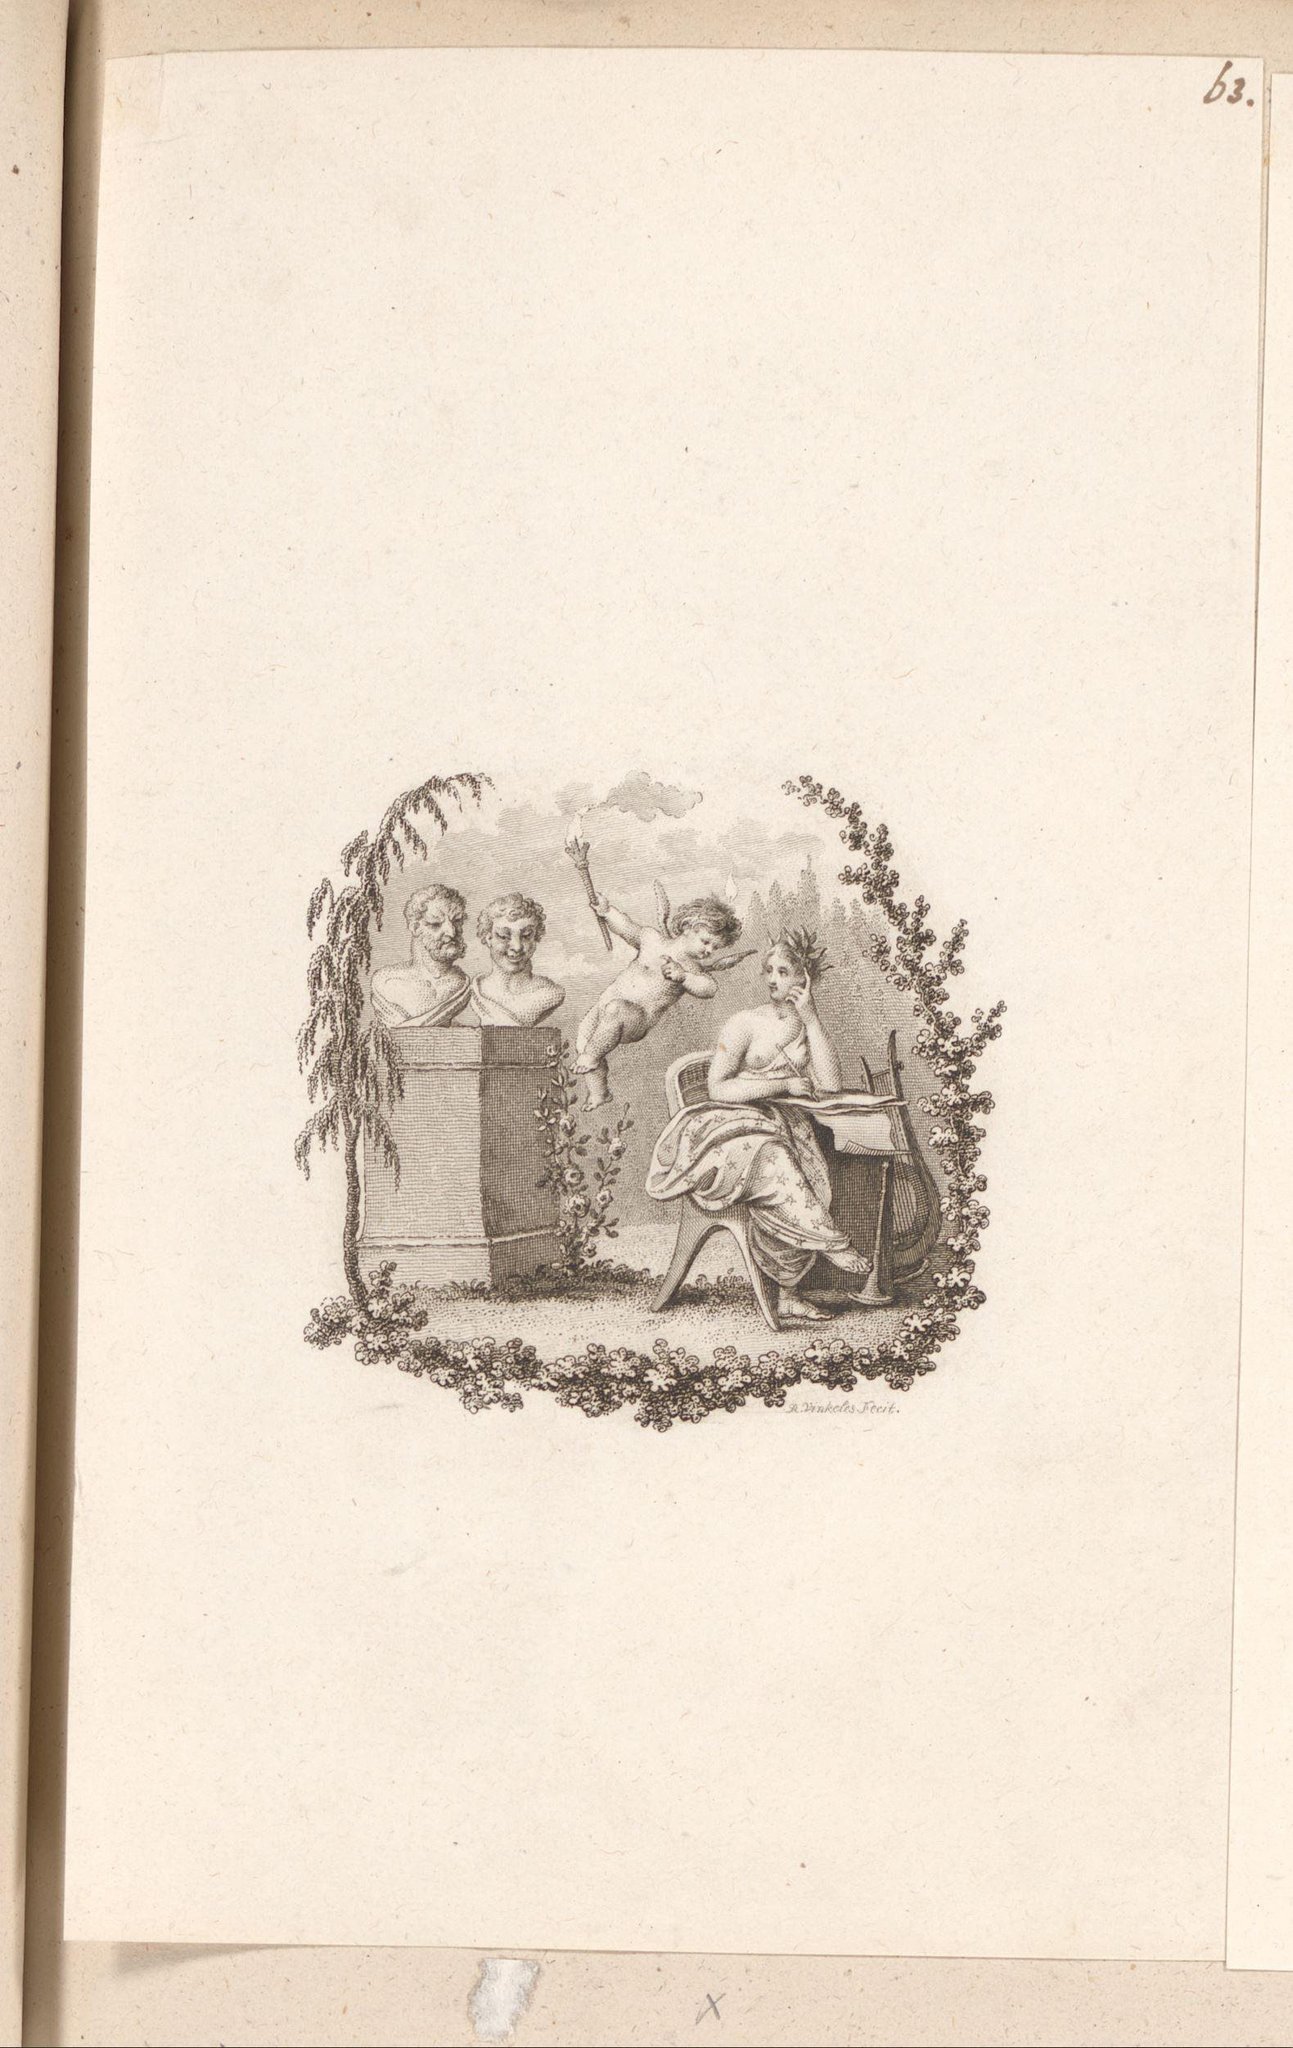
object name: album leaf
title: Erato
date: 1813-1815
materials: paper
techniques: engraving, etching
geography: amsterdam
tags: title-page, erato (one of the muses); 'erato' (ripa)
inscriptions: inscription: ‘63’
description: Erato, de muze van de lyriek en liefdespoëzie, zit aan een schrijftafel. Tegen de tafel staat een fluit en een lier. Links een putto met fakkel en een sokkel met twee bustes. De prent maakt deel uit van een album.